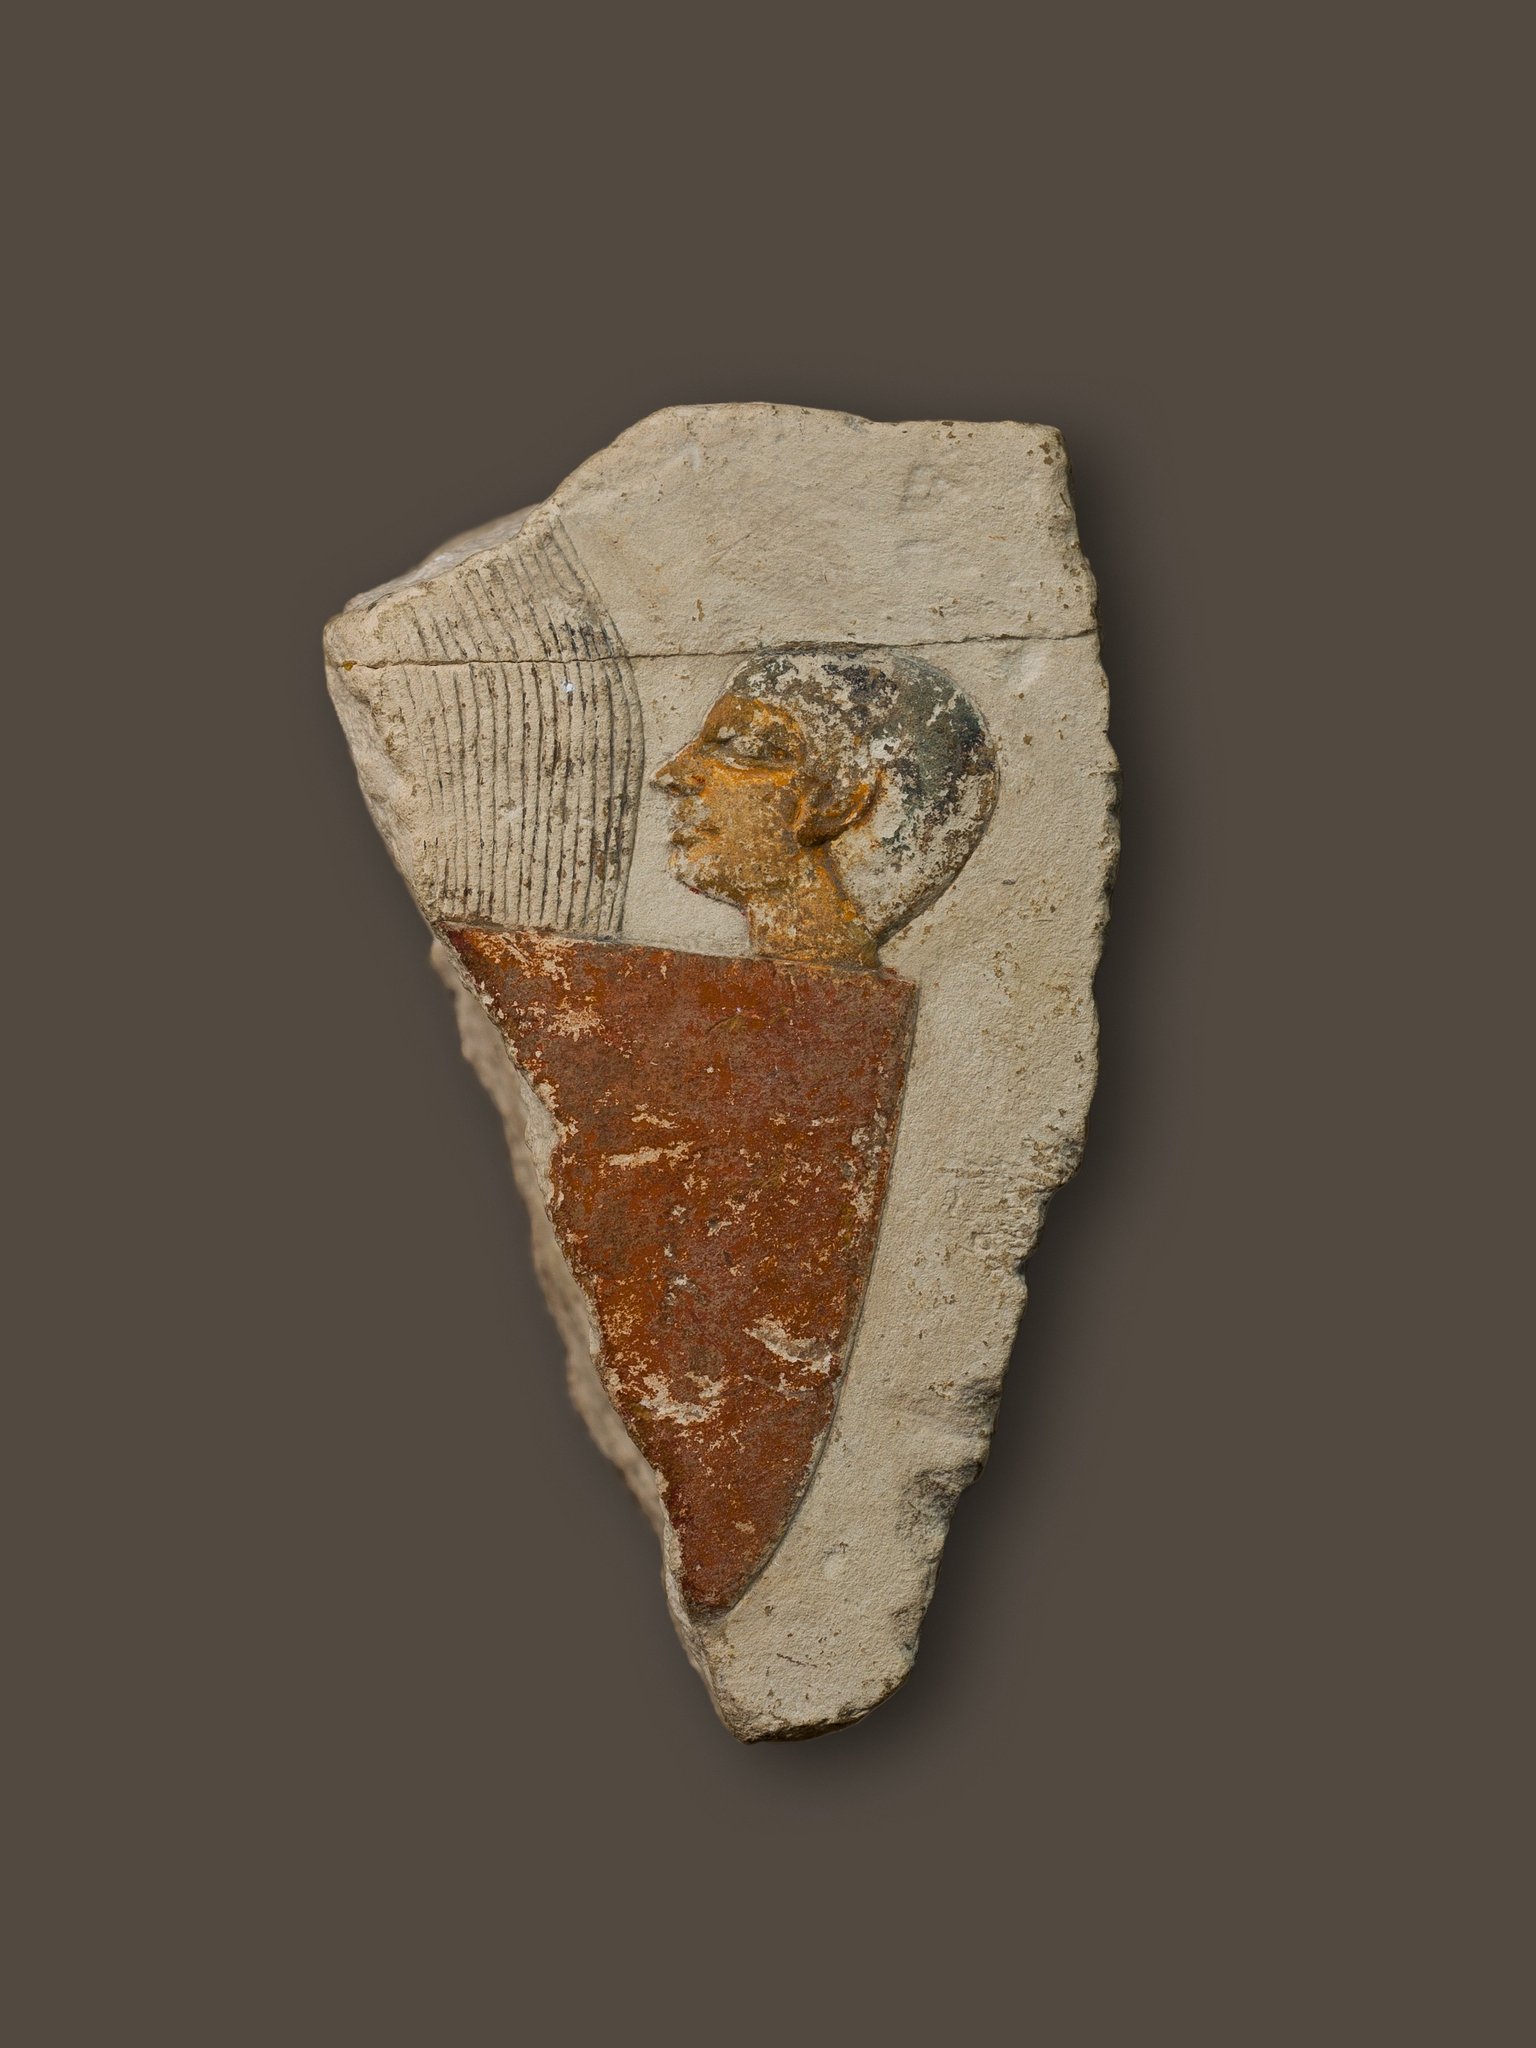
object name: relief, amenemhat i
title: Fragment of relief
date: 1981-1952 BCE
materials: limestone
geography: egypt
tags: human figures